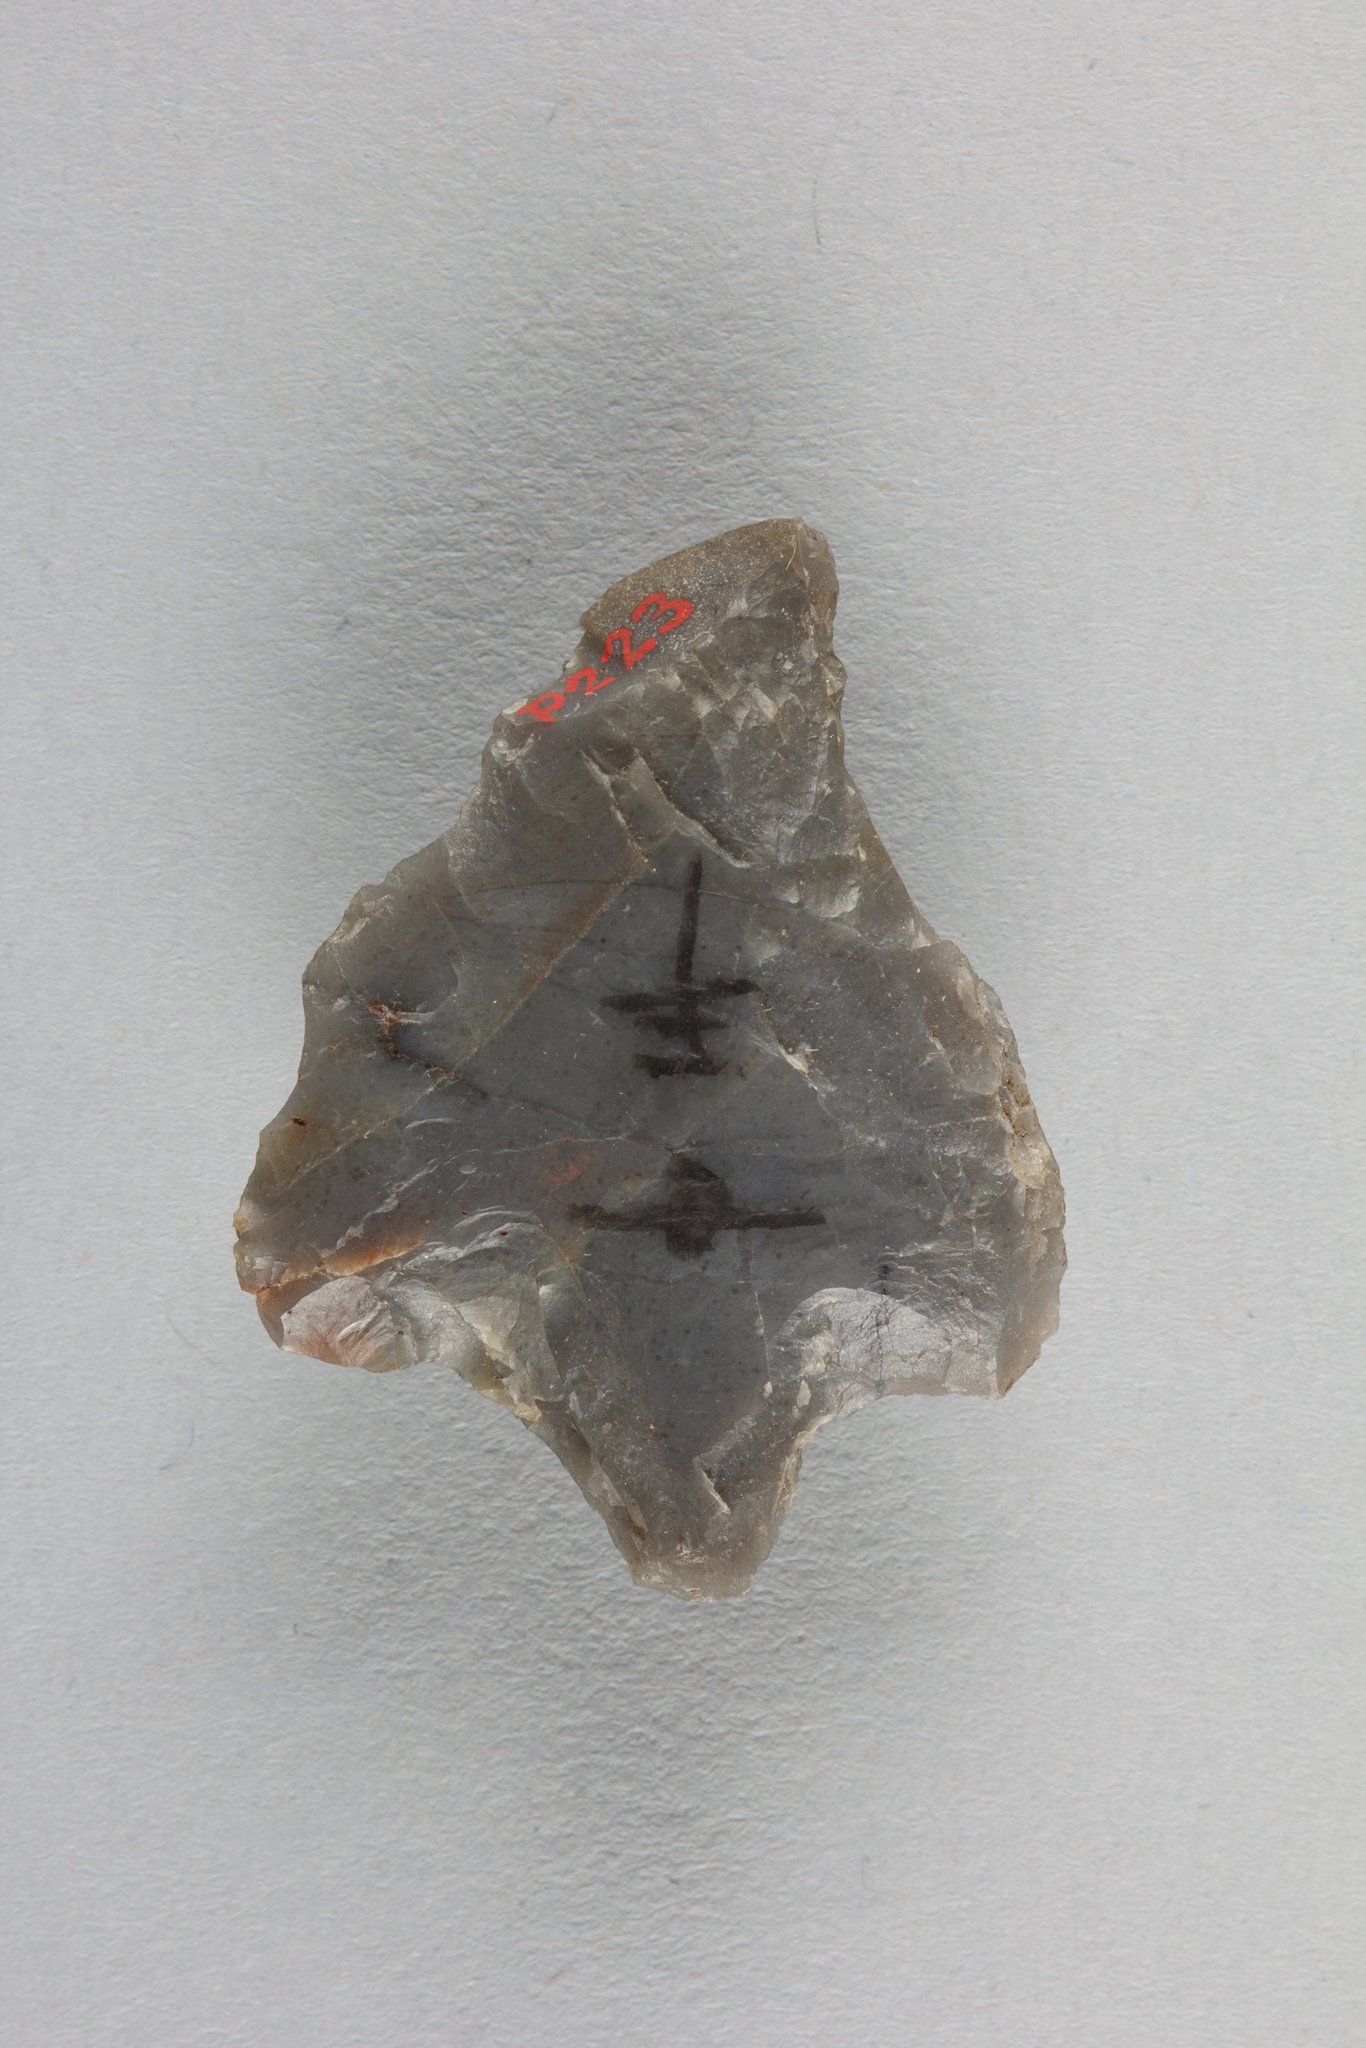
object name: arrowhead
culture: japanese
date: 1500-1000 BCE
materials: stone